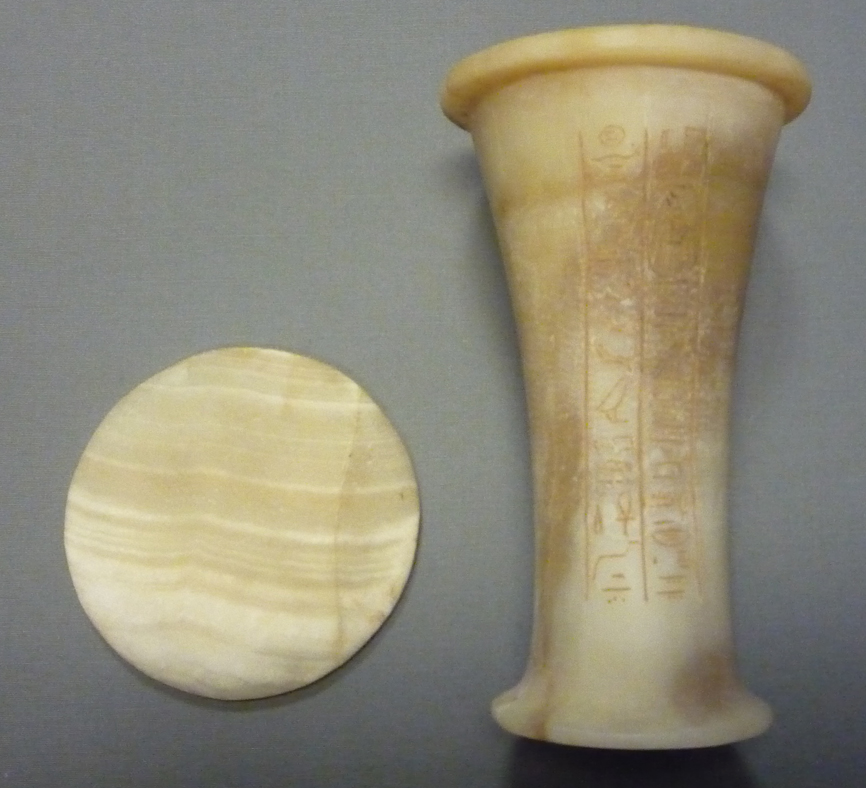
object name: ointment jar, foundation deposit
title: Ointment Jar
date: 1479-1458 BCE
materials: stone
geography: egypt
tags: hieroglyphs